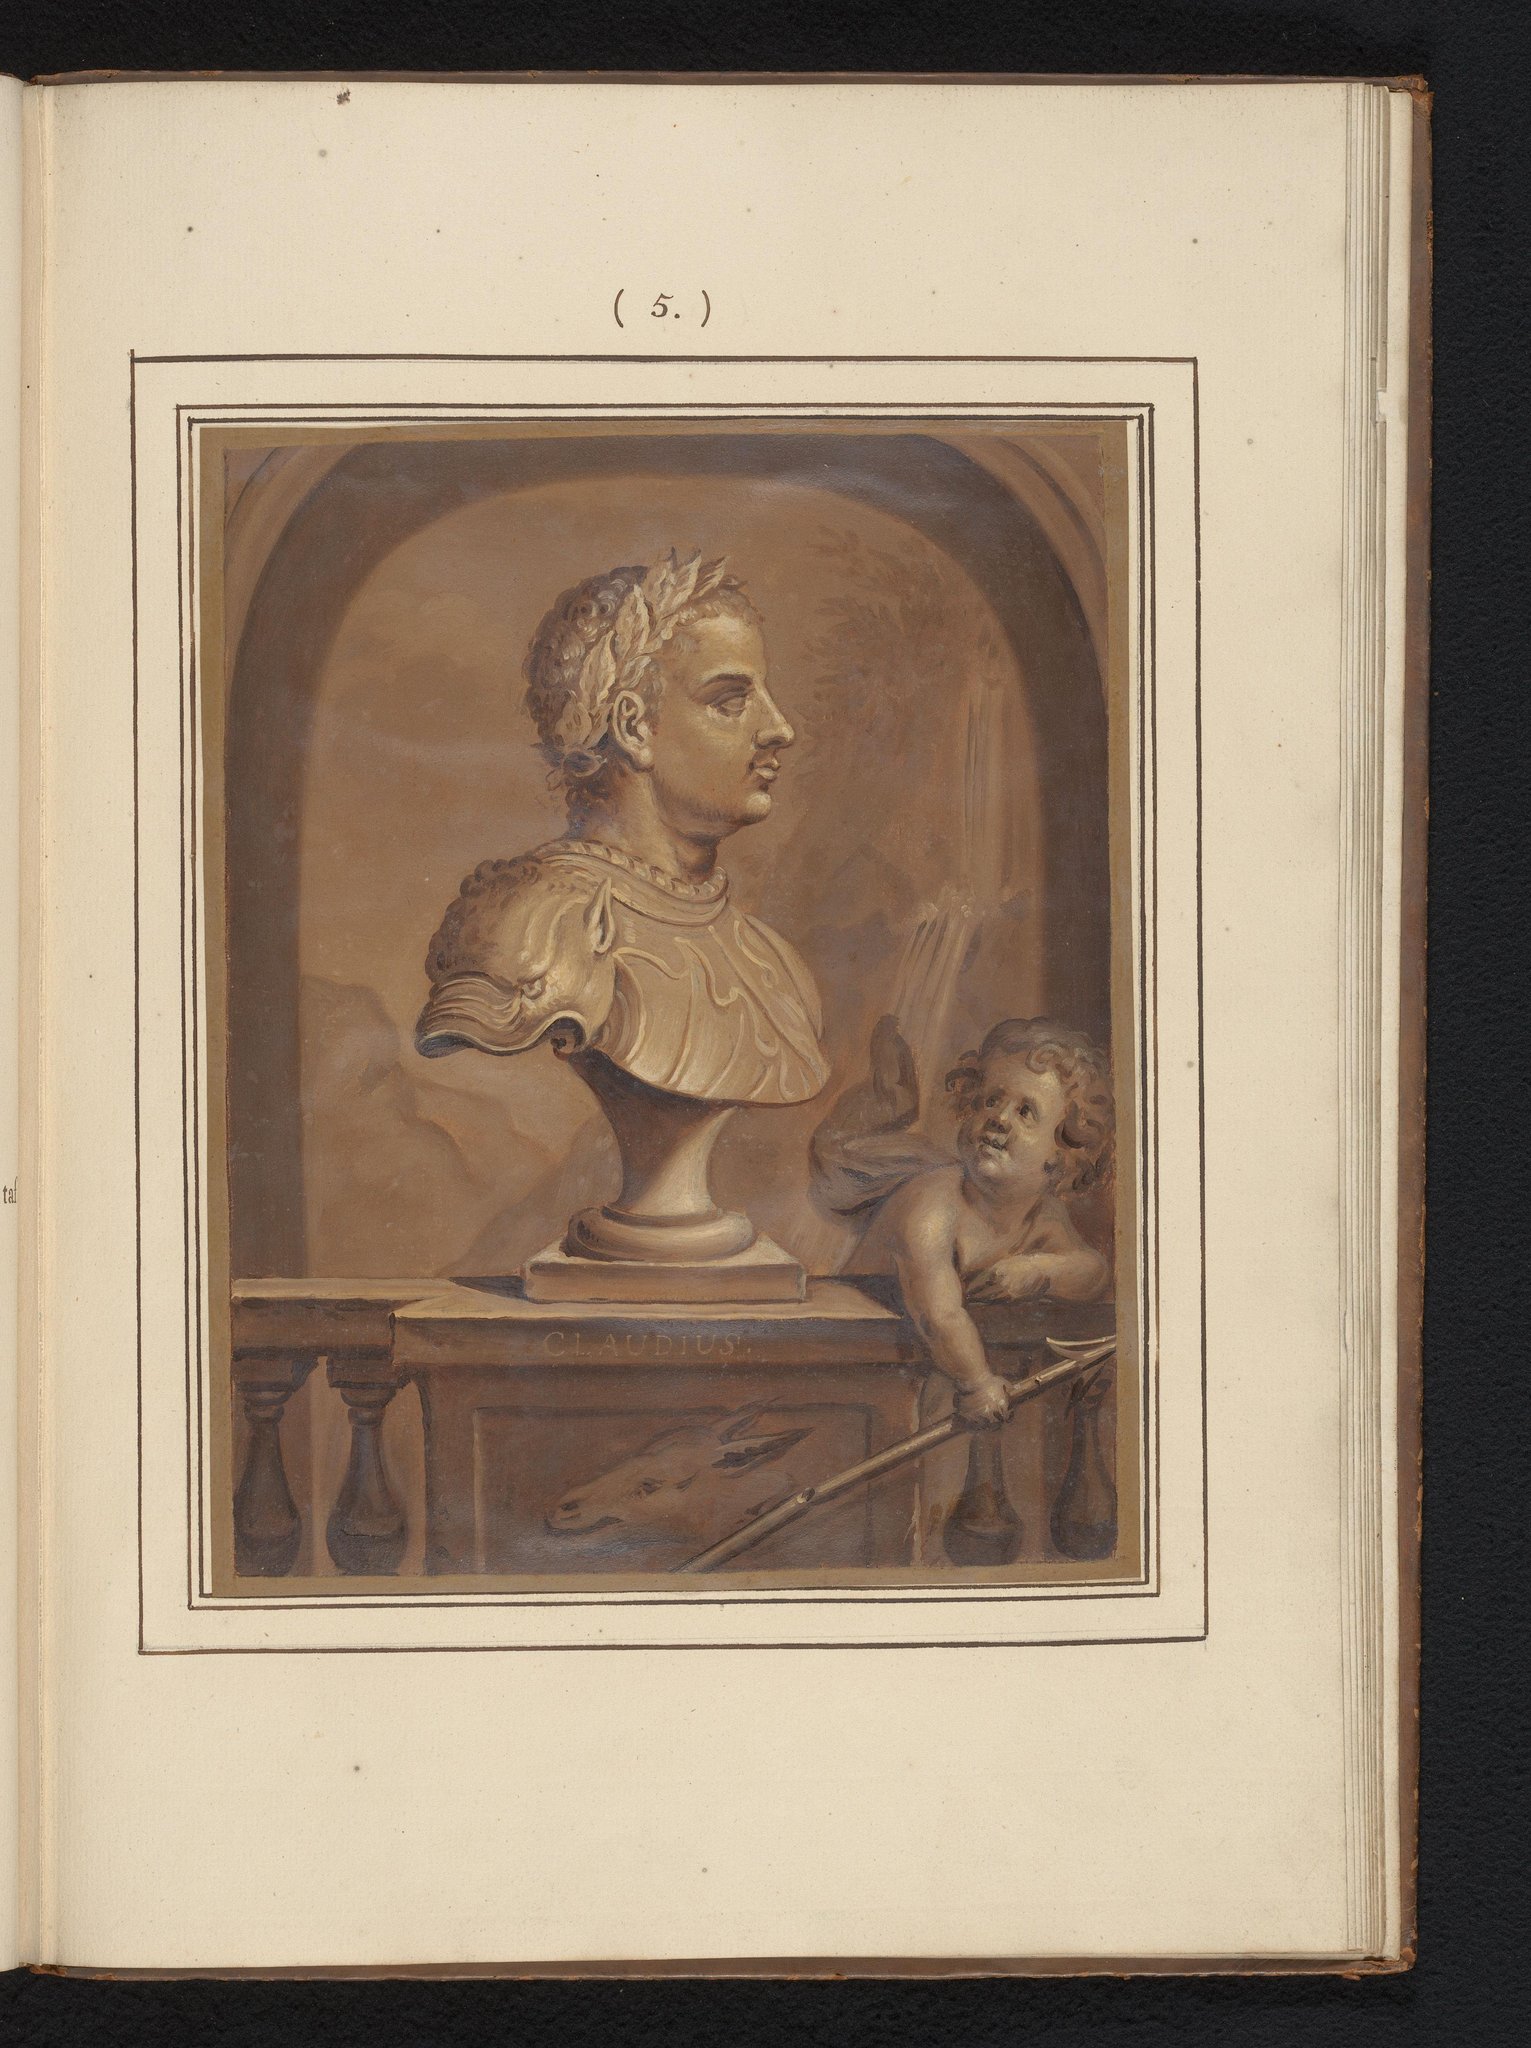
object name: album leaf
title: Portret van keizer Claudius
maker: pieter anthony wakkerdak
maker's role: print maker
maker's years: 1729-1774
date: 1773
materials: paint, paper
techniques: brush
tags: historical persons, emperor, crowning with laurel, cupids: 'amores', 'amoretti', 'putti'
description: Tekening maakt deel uit van een manuscript.